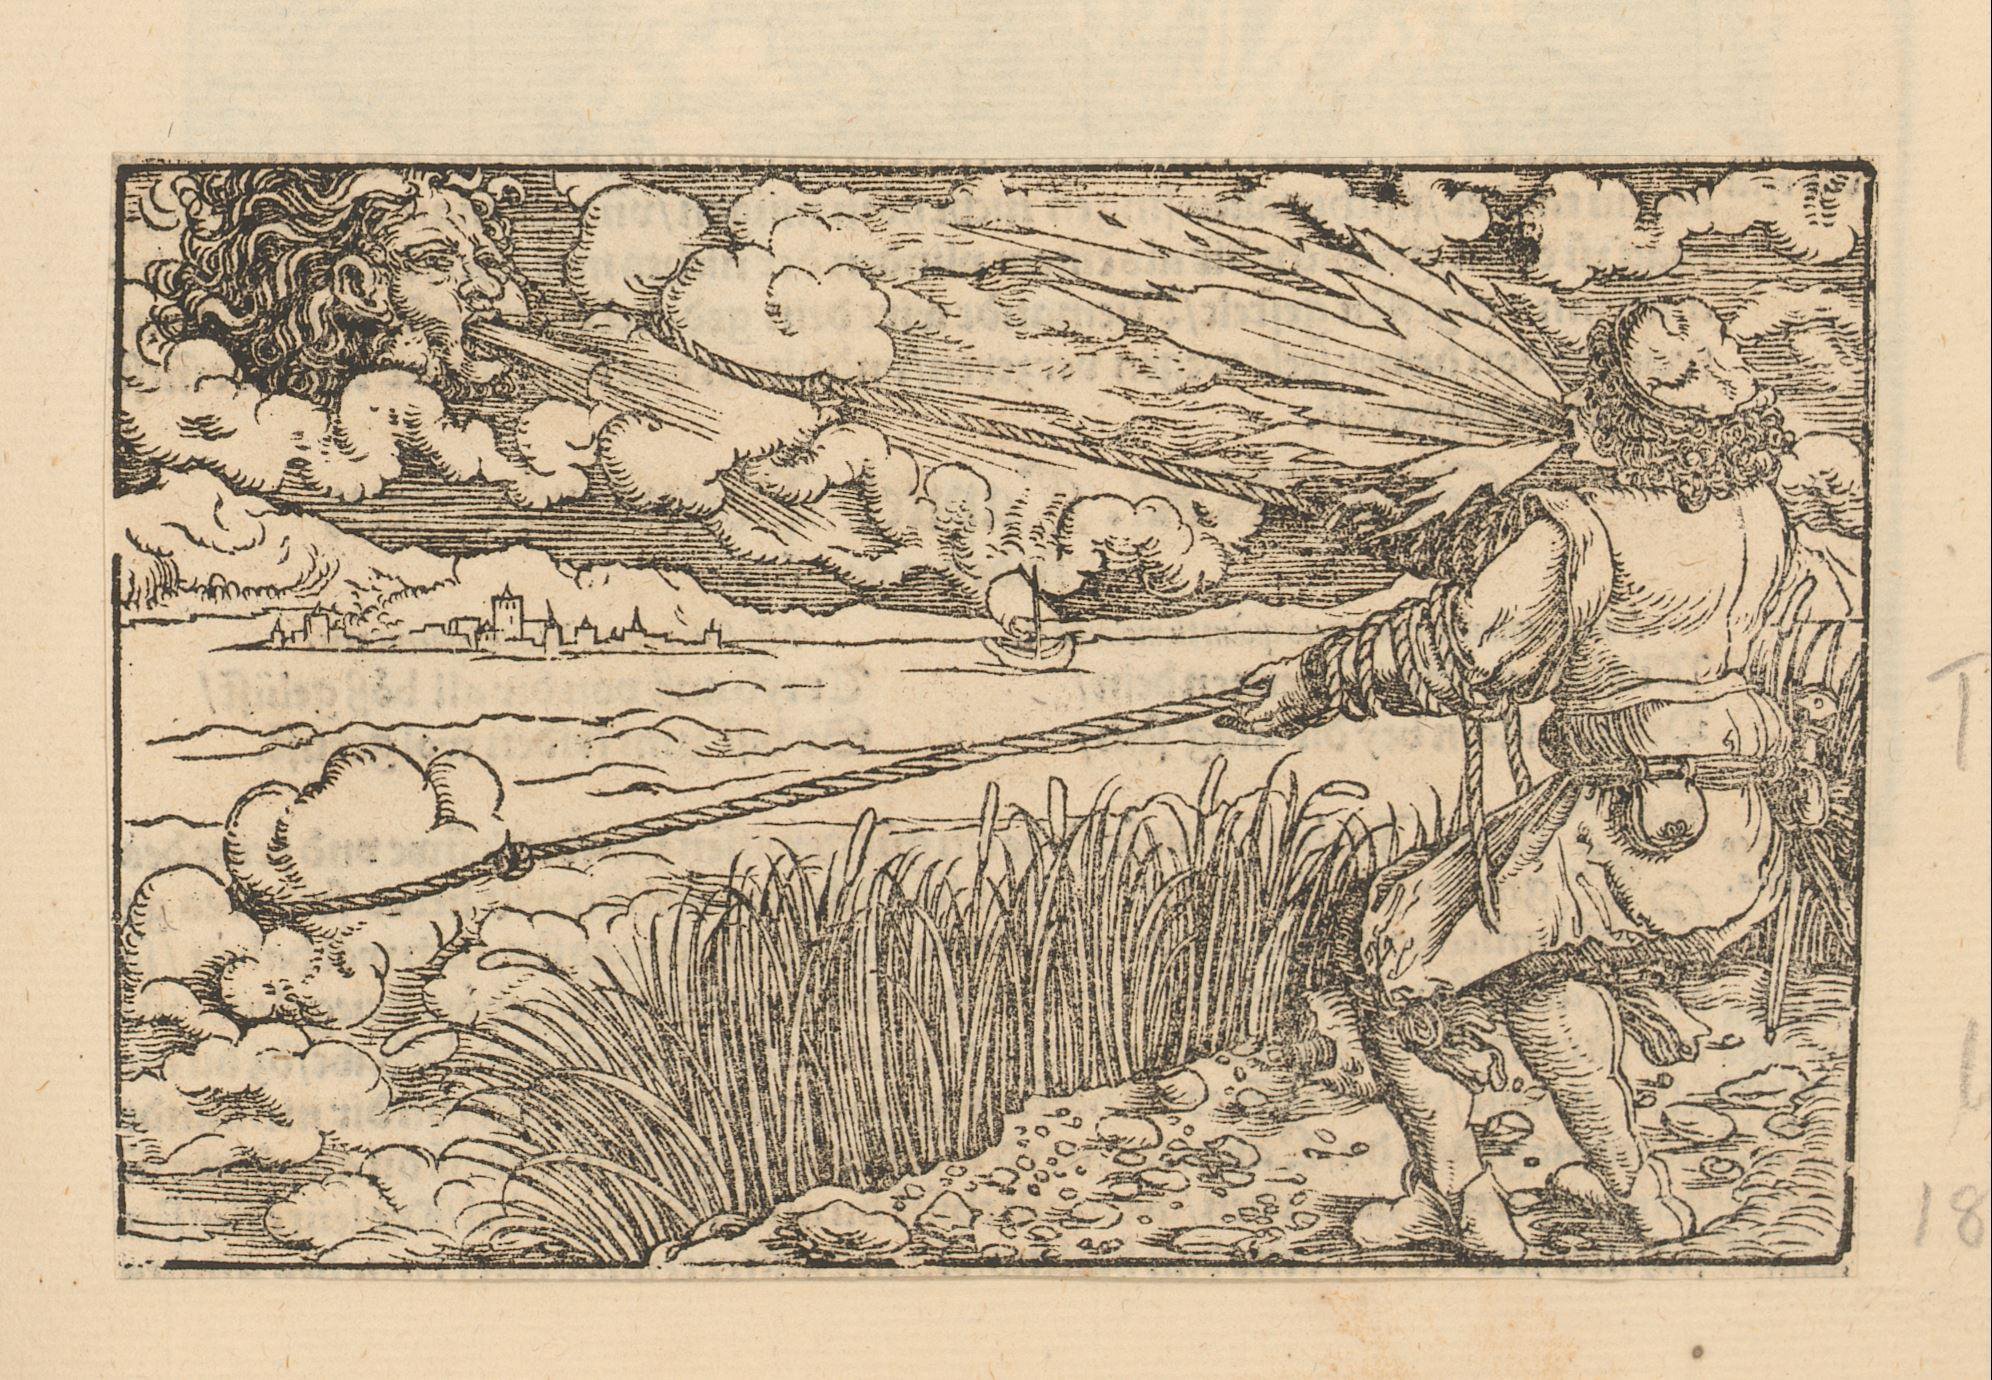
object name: print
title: Landarbeider probeert een wolk te vangen terwijl een wolk terugblaast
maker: Anonymous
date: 1514-1532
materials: paper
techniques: letterpress printing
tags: clouds, proverbs, sayings, etc., storm at sea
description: Deze prent is gebruikt in: Petrarca, Francesco. Von der Artzney bayder Glück, des guten und widerwertigen: unnd weß sich ain yeder inn Gelück und Unglück halten sol (...). Augsburg: Heinrich Steiner, 1532. Deze uitgave is ook bekend onder de titel 'Trostspiegel in Glück und Unglück'. De voorstelling in de prent representeert het gezegde 'hoffen heißt Wolken fangen wollen', vrij vertaalt 'hopen kan betekenen dat je wolken wilt vangen', en slaat op iemand die droomt en hoopvol is.